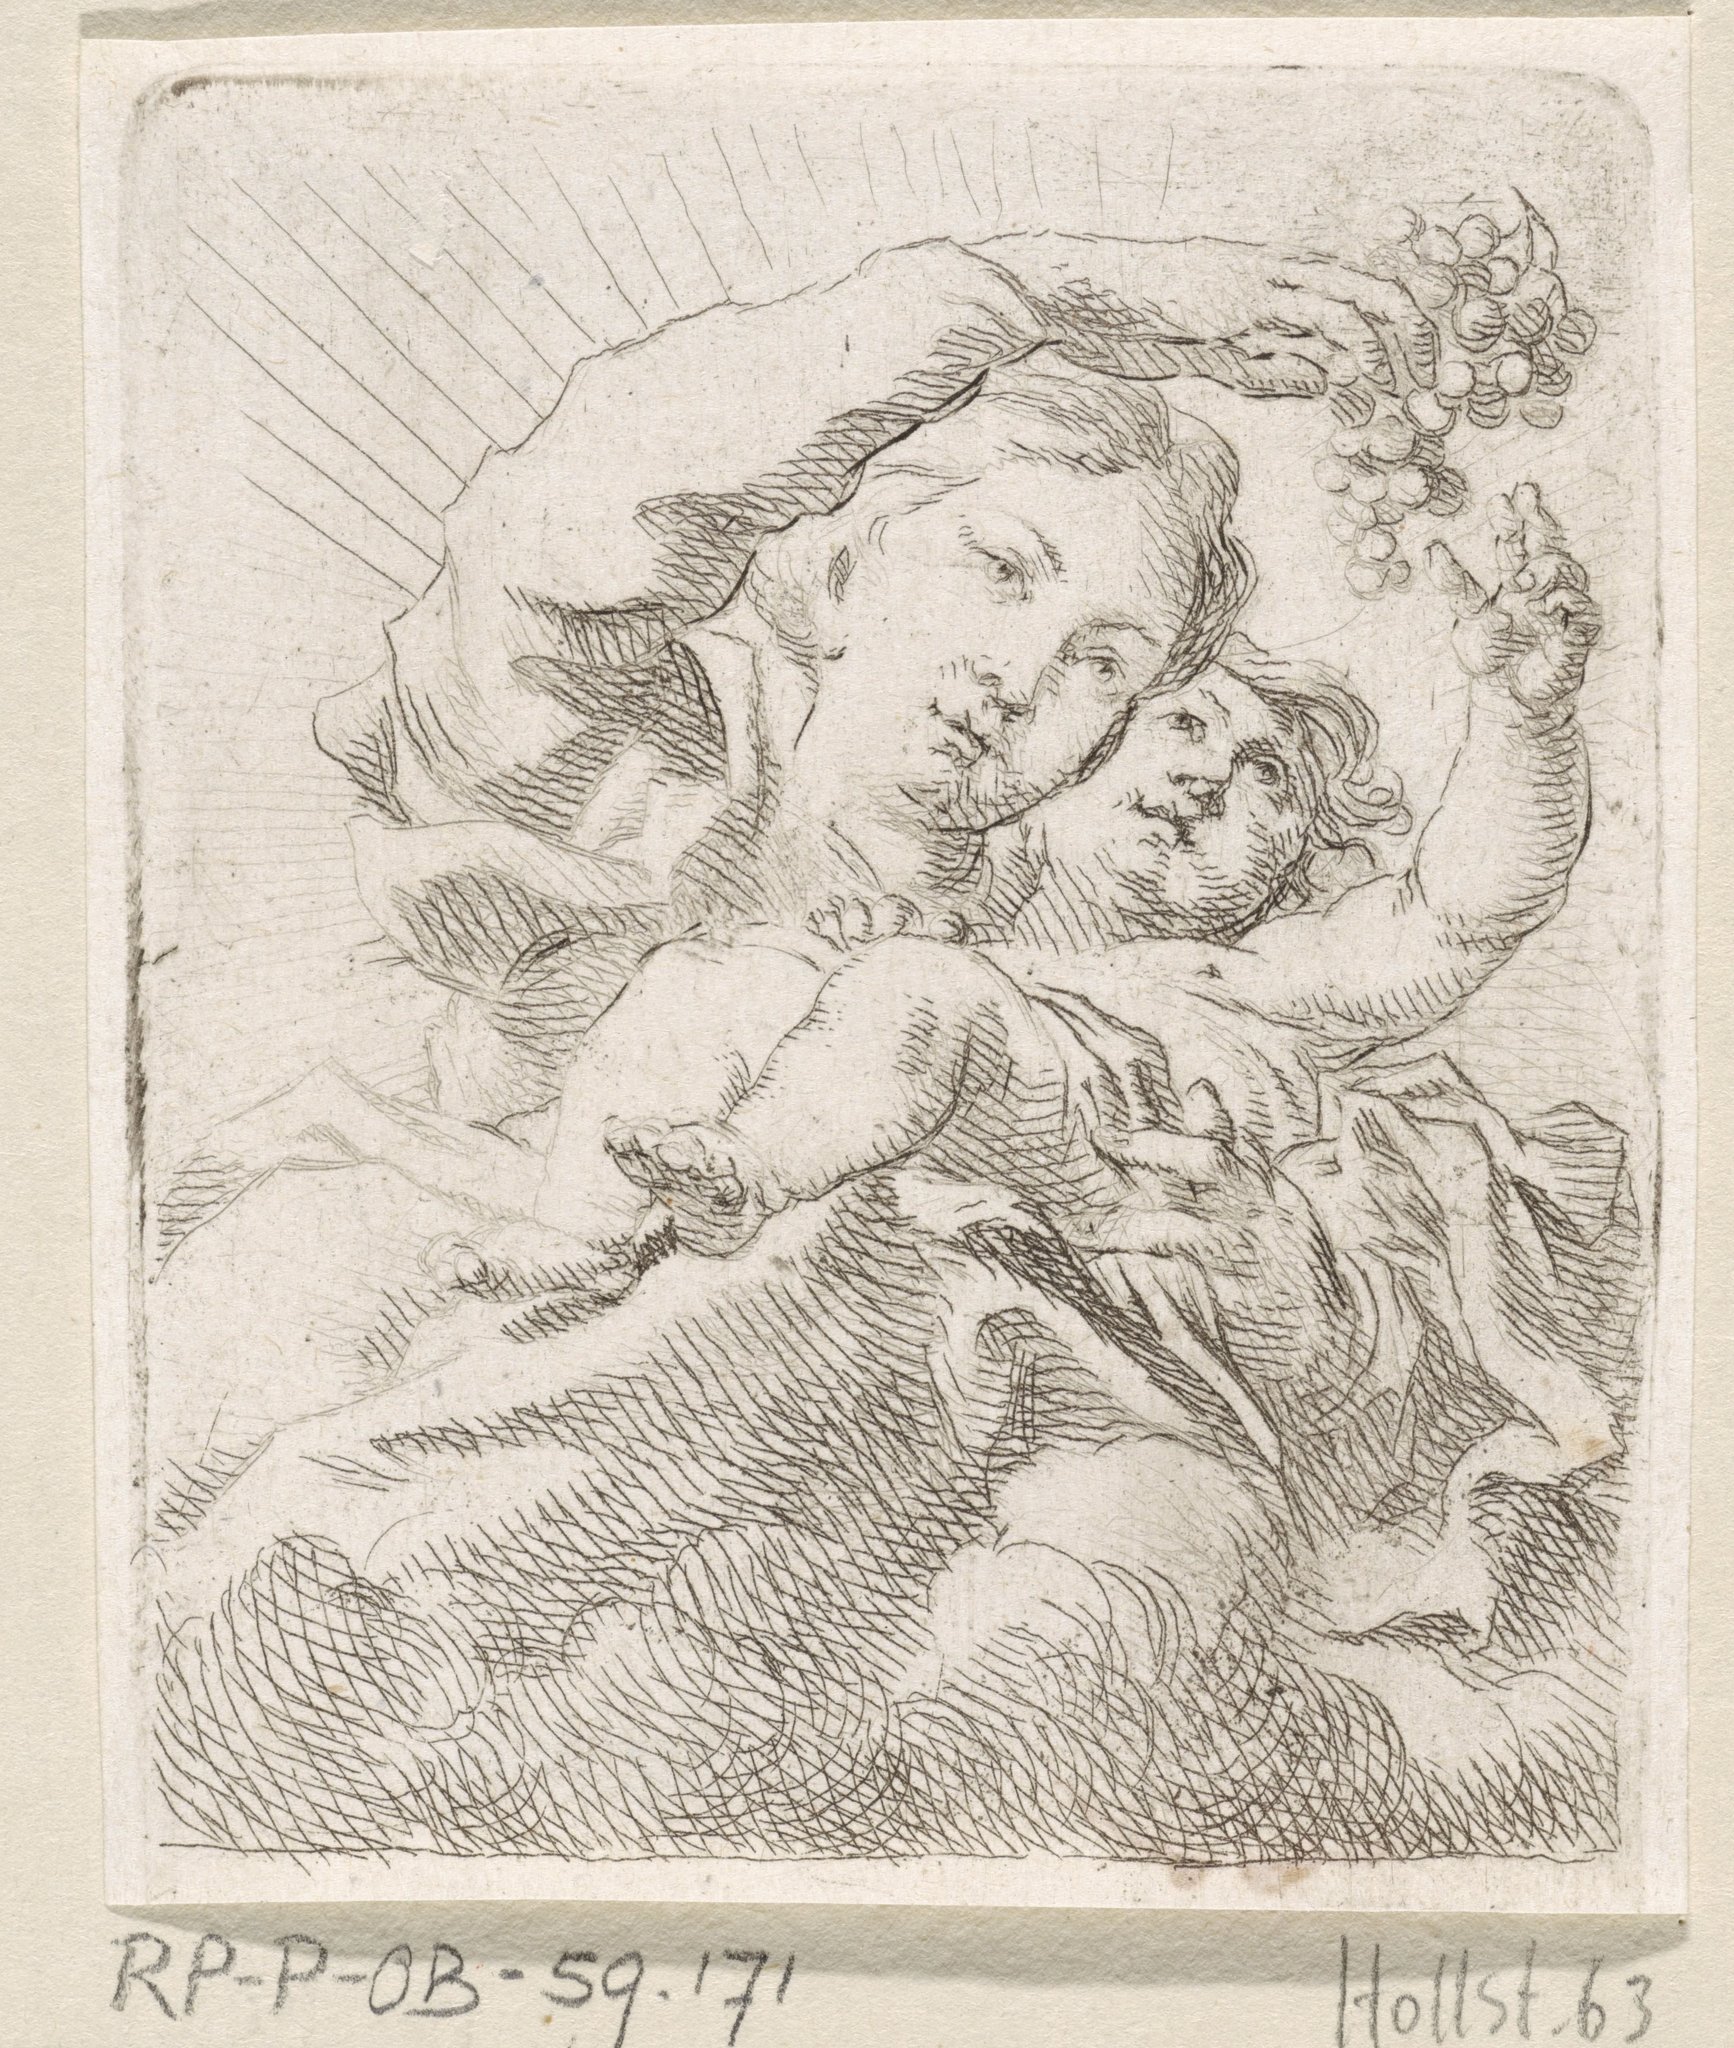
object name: print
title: Madonna met kind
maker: cornelis schut (i)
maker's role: draughtsman, print maker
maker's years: 1597-1655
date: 1618-1655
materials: paper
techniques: etching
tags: christ-child accepting, reaching out for something ~ madonna-representations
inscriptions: collector's mark: Lugt 240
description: Maria zit op een wolk en houdt het Christuskind op haar schoot. Hij reikt naar de druiven die Maria in haar omhoog geheven hand houdt.